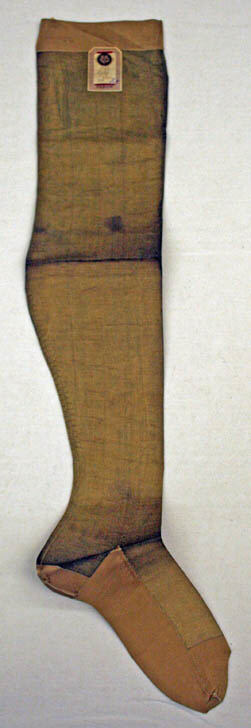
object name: stocking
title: Stockings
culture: french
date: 1885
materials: silk